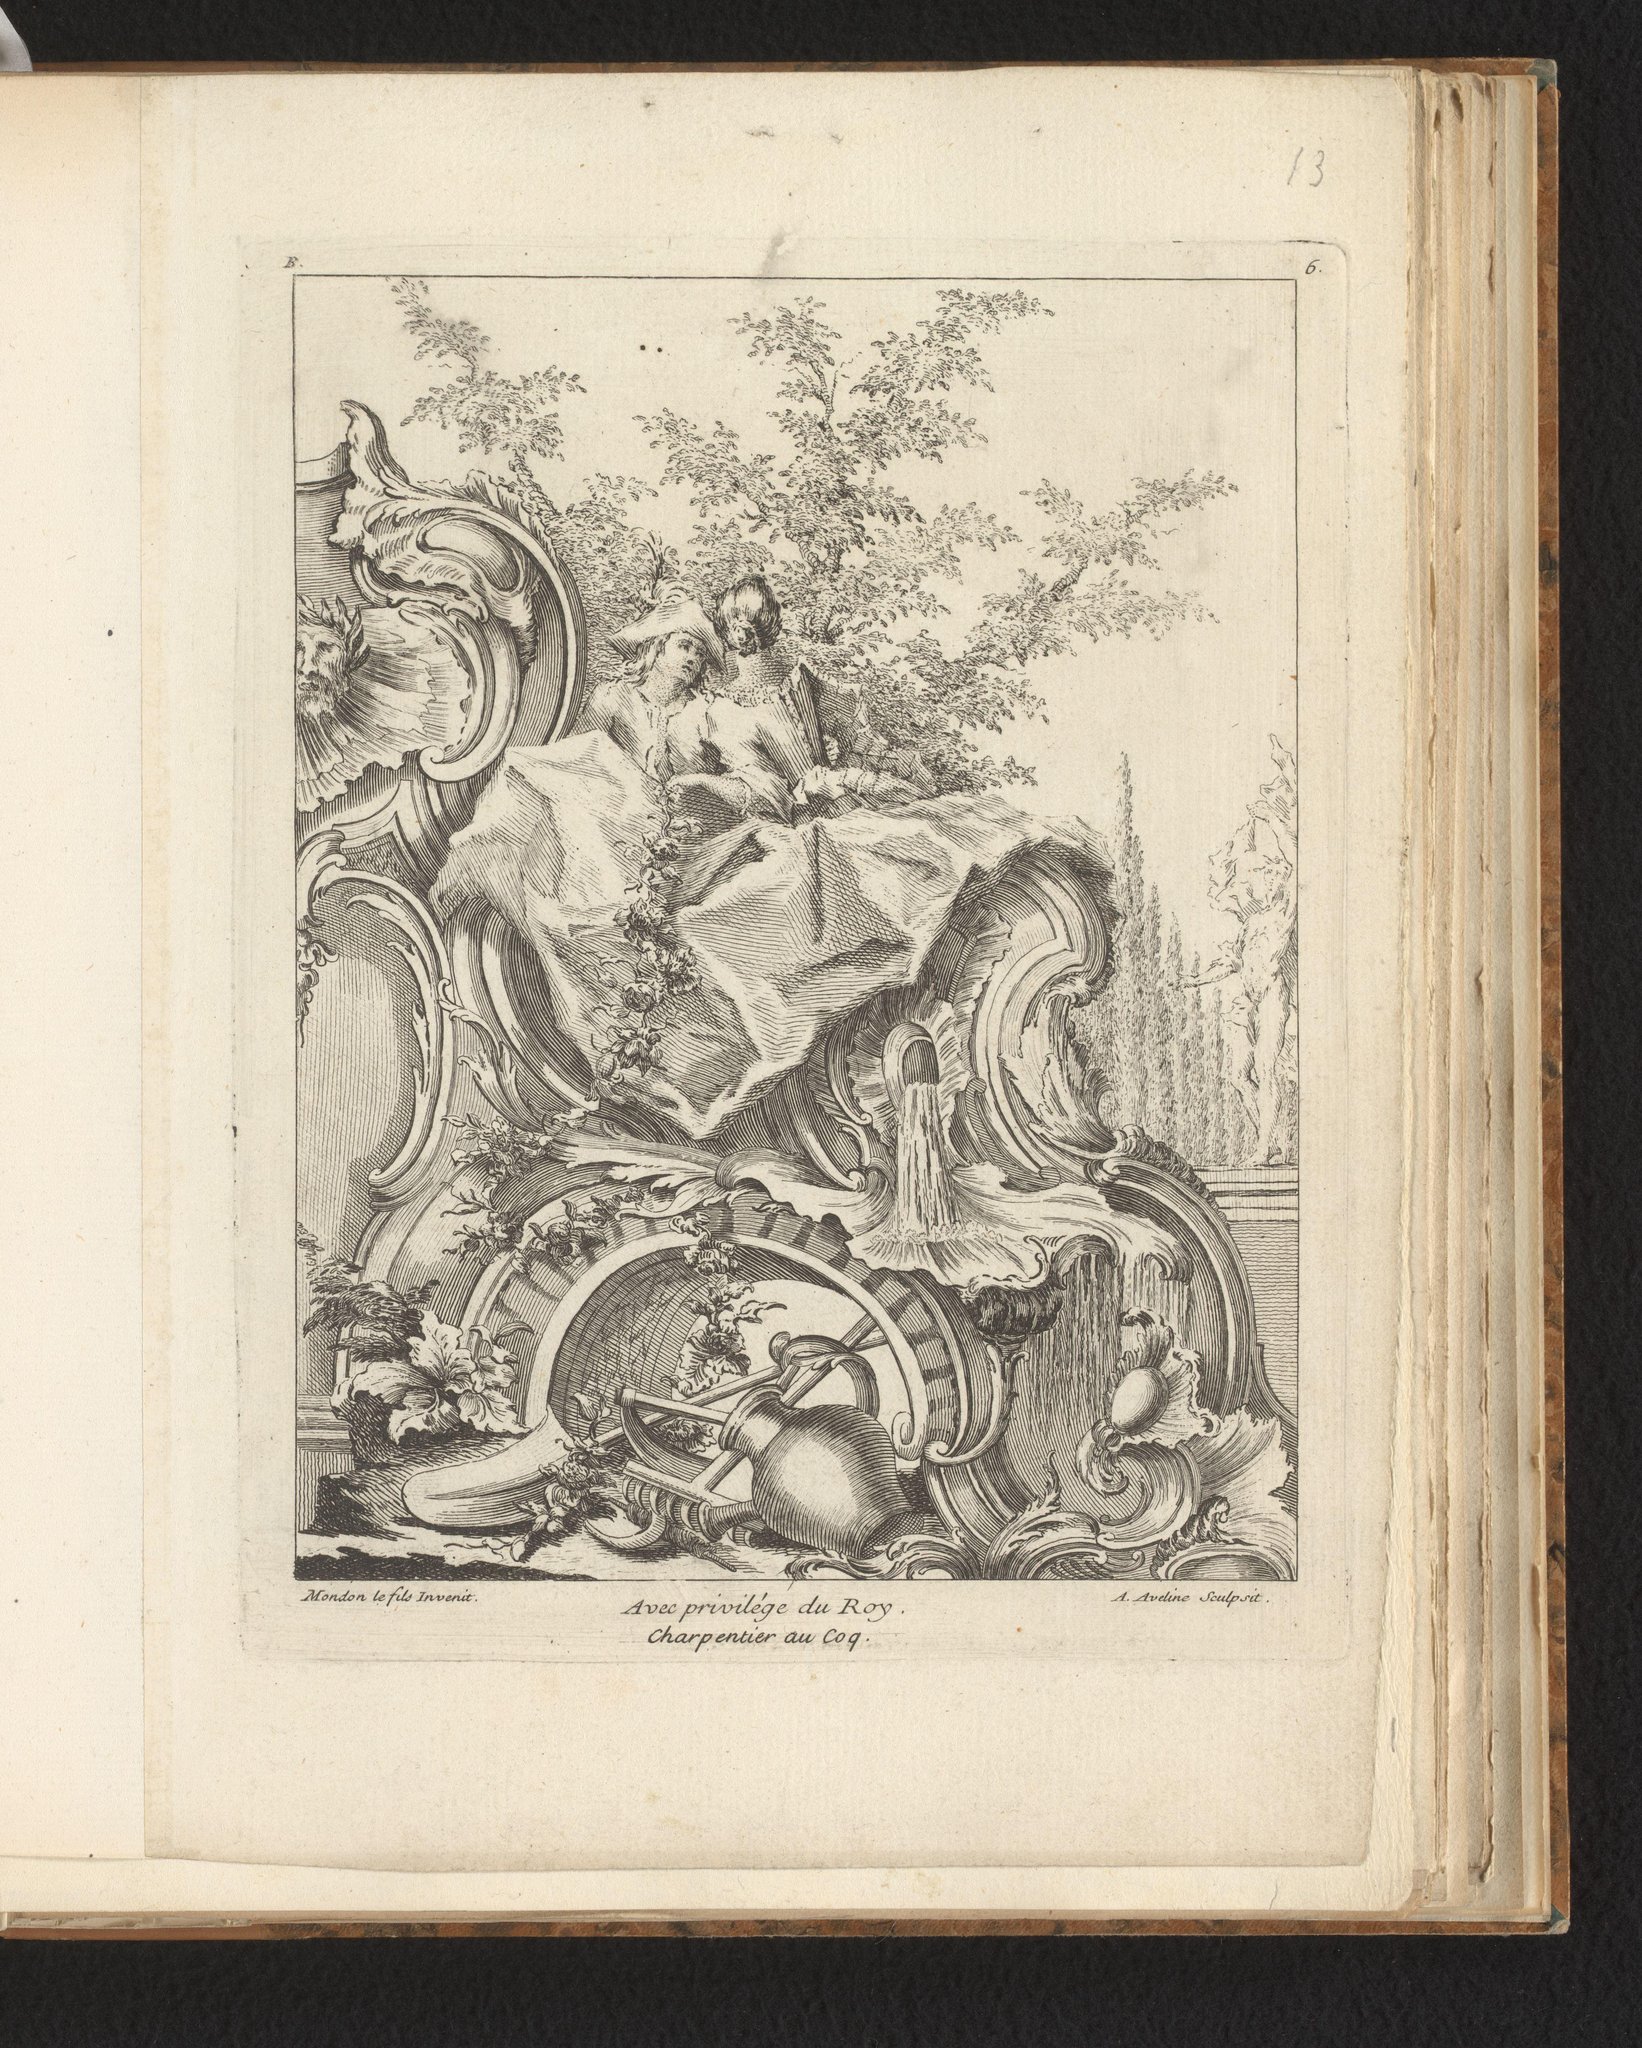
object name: album leaf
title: Serie van trofeeën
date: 1736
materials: paper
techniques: etching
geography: paris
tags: rocaille ornament, gardening-tools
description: Deze serie is linksboven genummerd met een letter B. Prent maakt deel uit van een album.